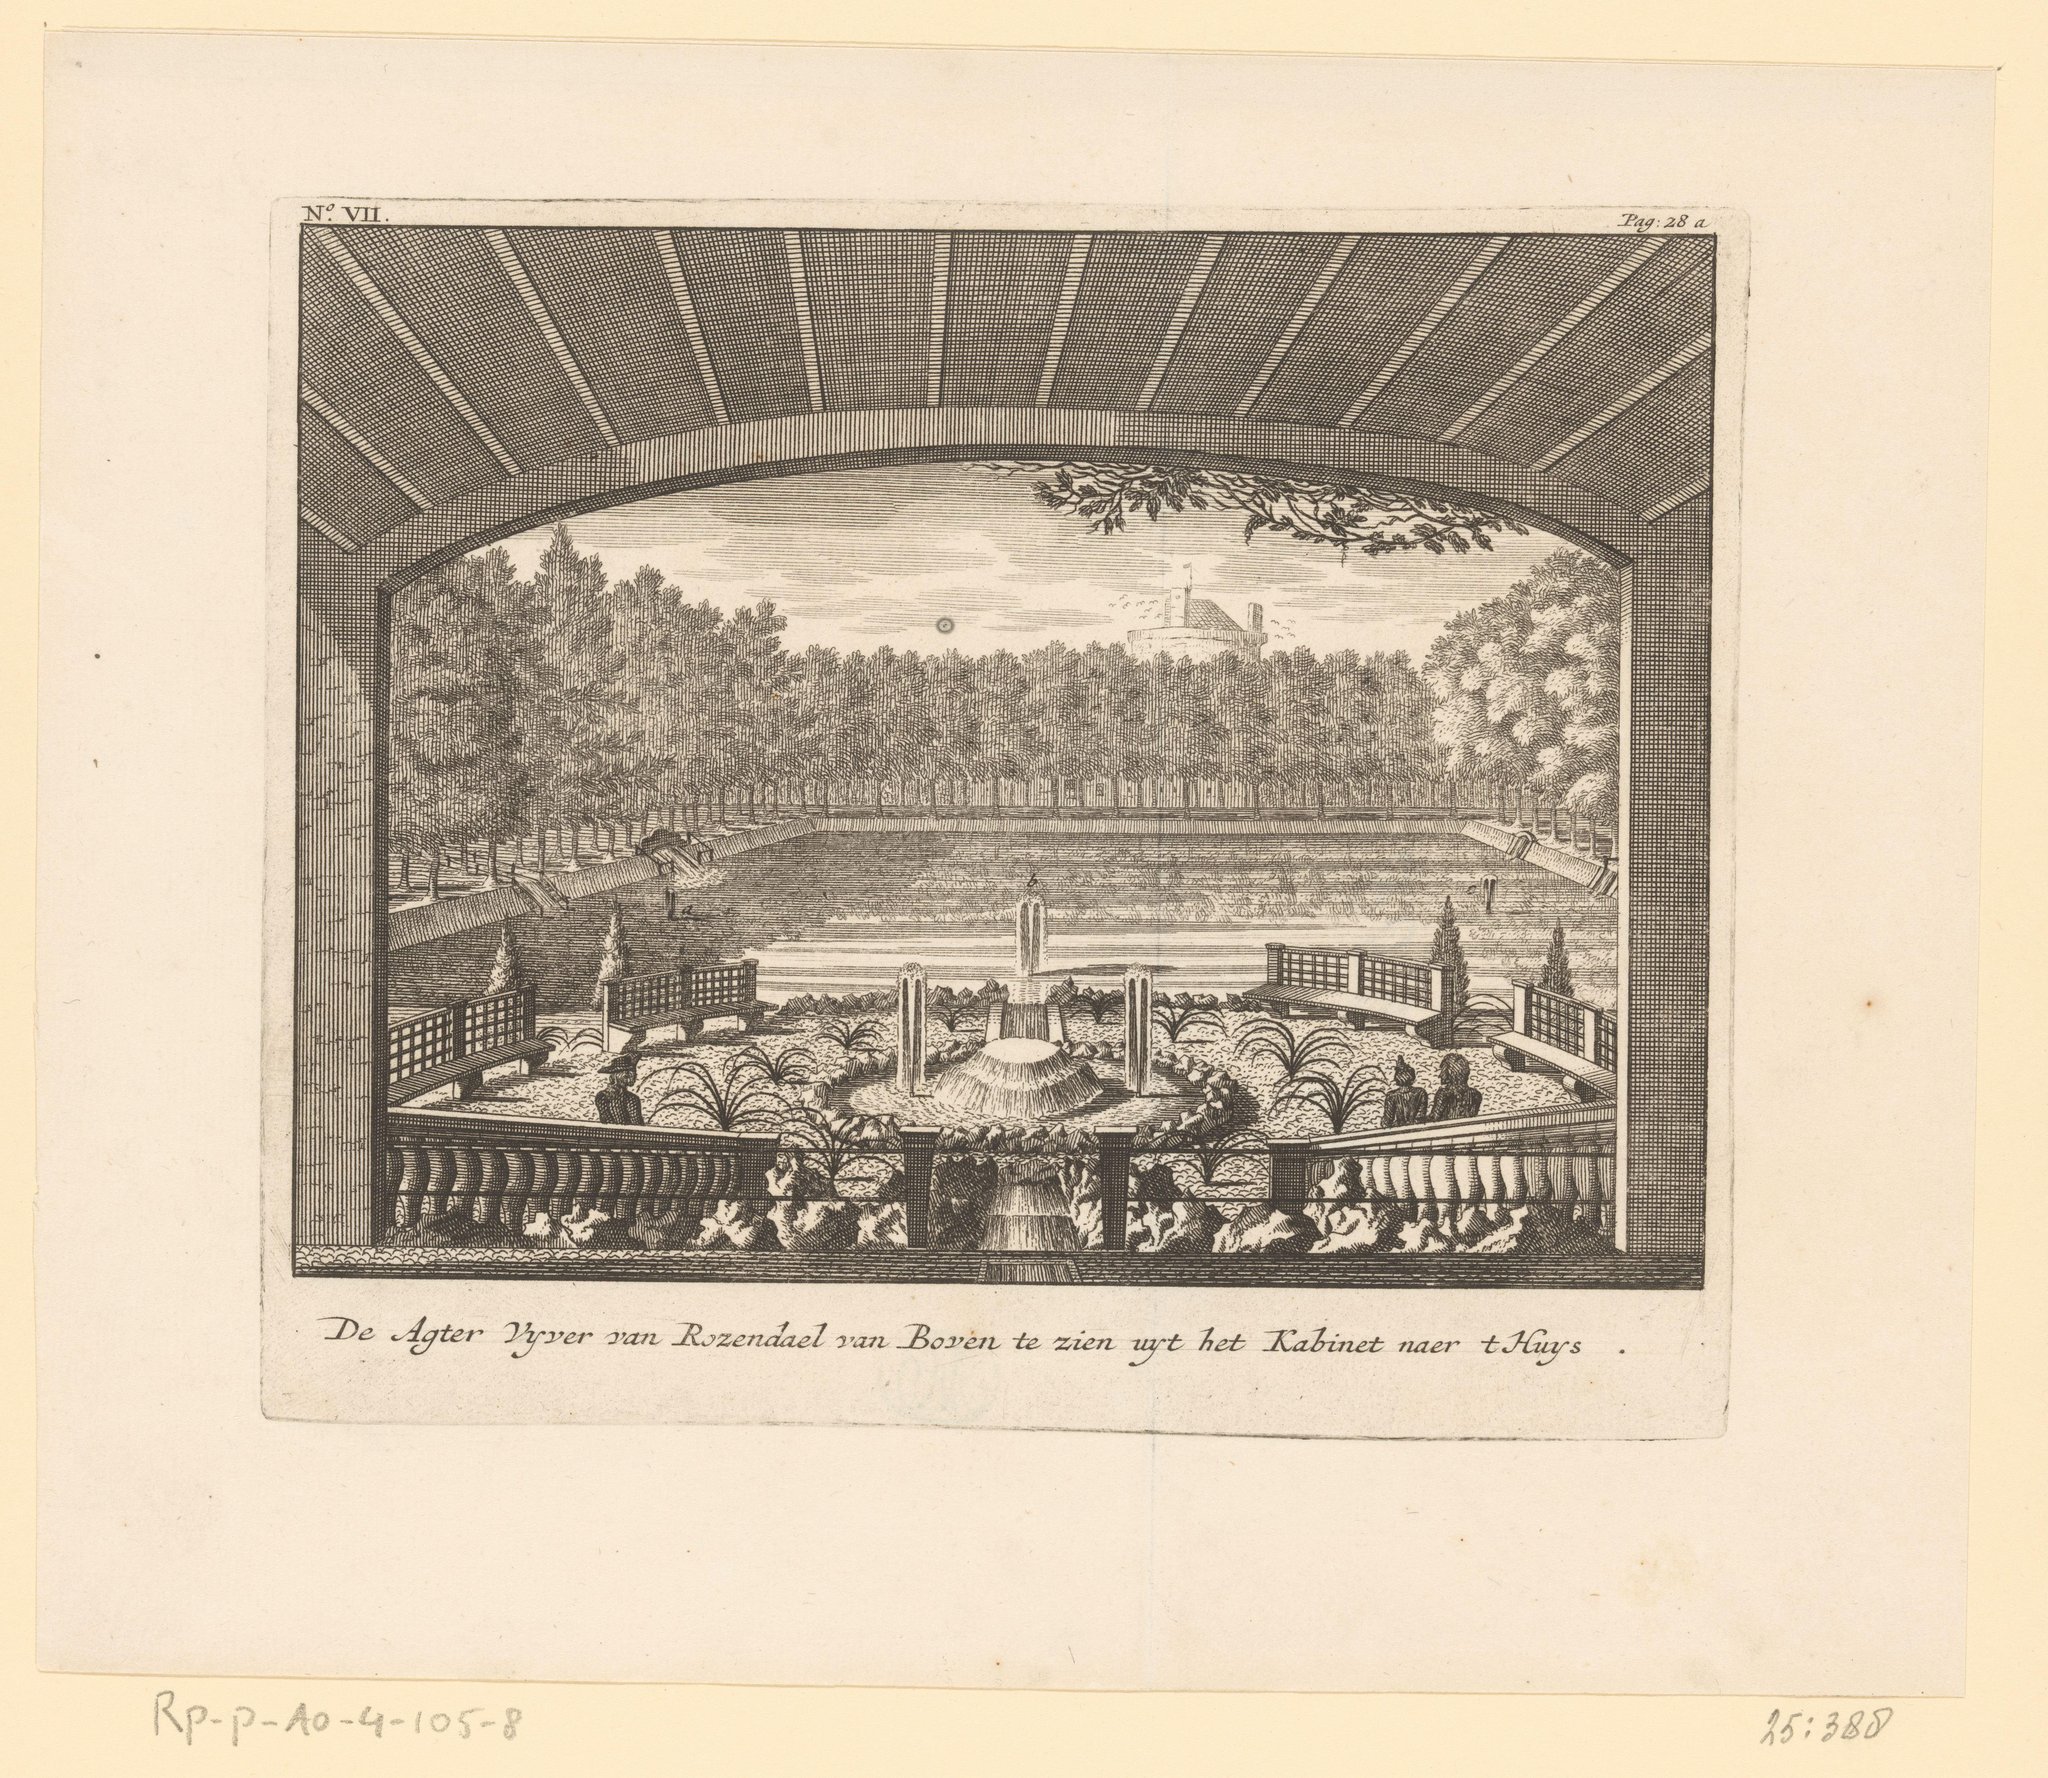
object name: book illustration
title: De agter vyver van Rozendael van boven te zien uyt het kabinet naer t Huys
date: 1718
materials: paper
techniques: engraving, etching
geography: amsterdam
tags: castle, garden fountain, french or architectonic garden; formal garden, garden pond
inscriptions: collector's mark: Lugt 195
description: Prent ook gebruikt in: Outrein, Johannes d’. Wegwyser door de heerlykheid Roosendaal ofte, de Roosendaalsche vermakelykheden. 3e druk. Amsterdam: Gerard van Keulen, 1718.